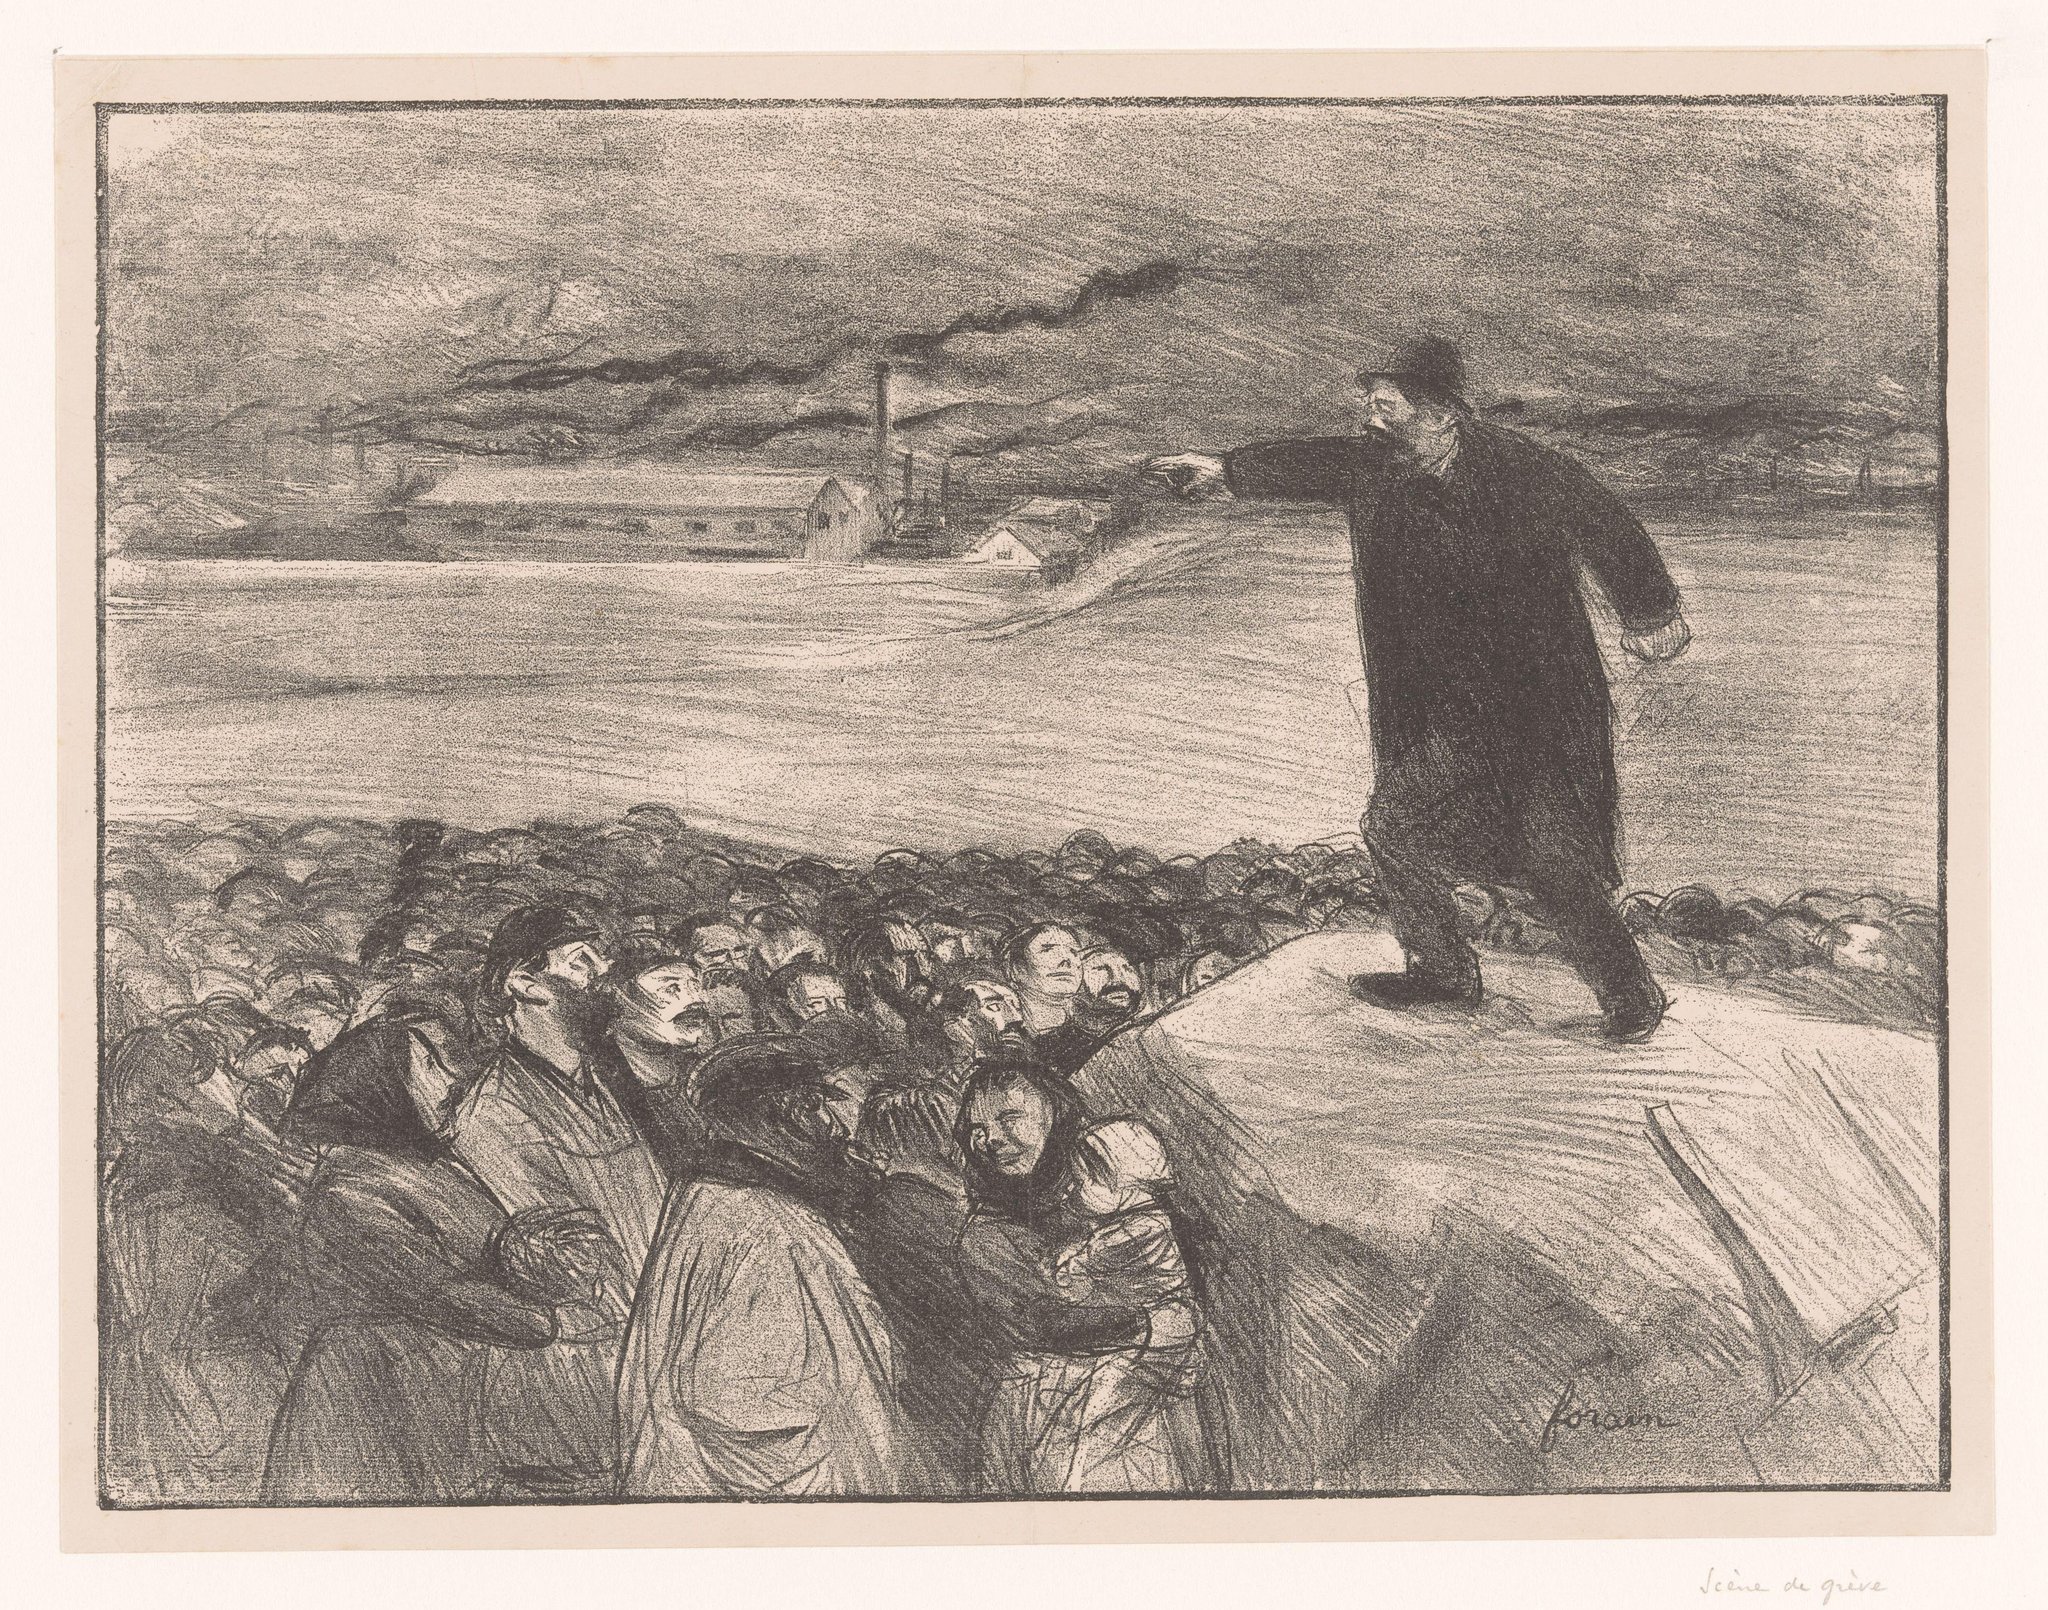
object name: print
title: Staking van fabrieksarbeiders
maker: jean-louis forain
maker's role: painter, print maker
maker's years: 1852-1931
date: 1897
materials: paper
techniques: lithograph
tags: factory-building, factory in landscape, working class, labourers, strike (political demonstration)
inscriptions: collector's mark: Lugt 2228a